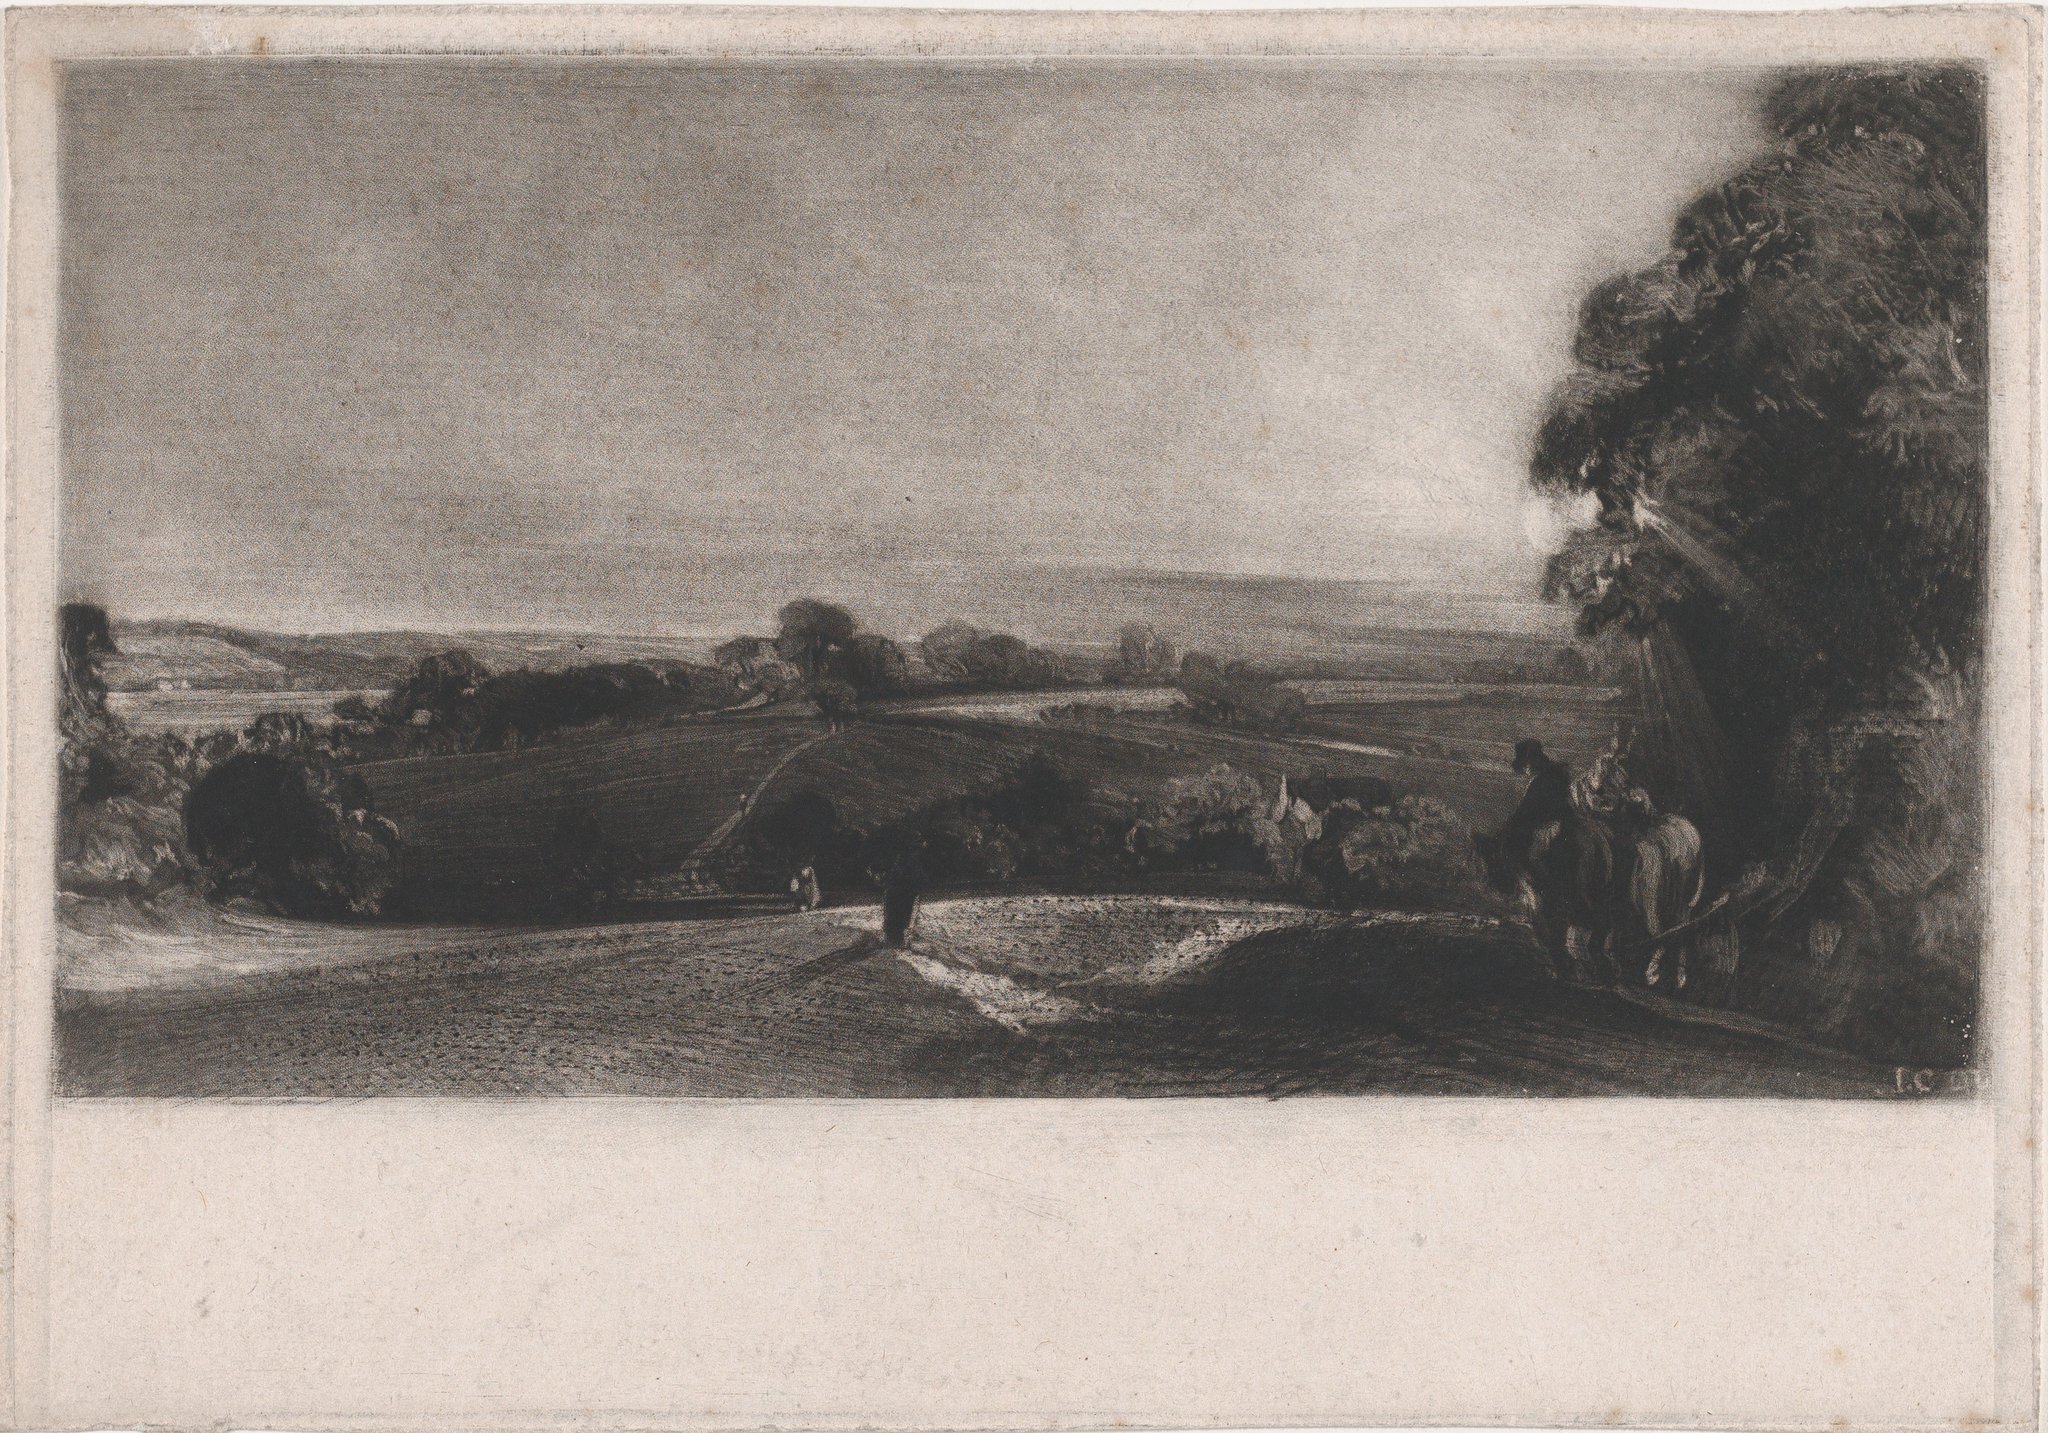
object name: print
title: Autumnal Sunset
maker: david lucas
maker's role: artist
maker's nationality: british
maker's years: 1802-1881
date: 1830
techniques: drypoint, mezzotint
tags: animals,landscapes,autumn,evening